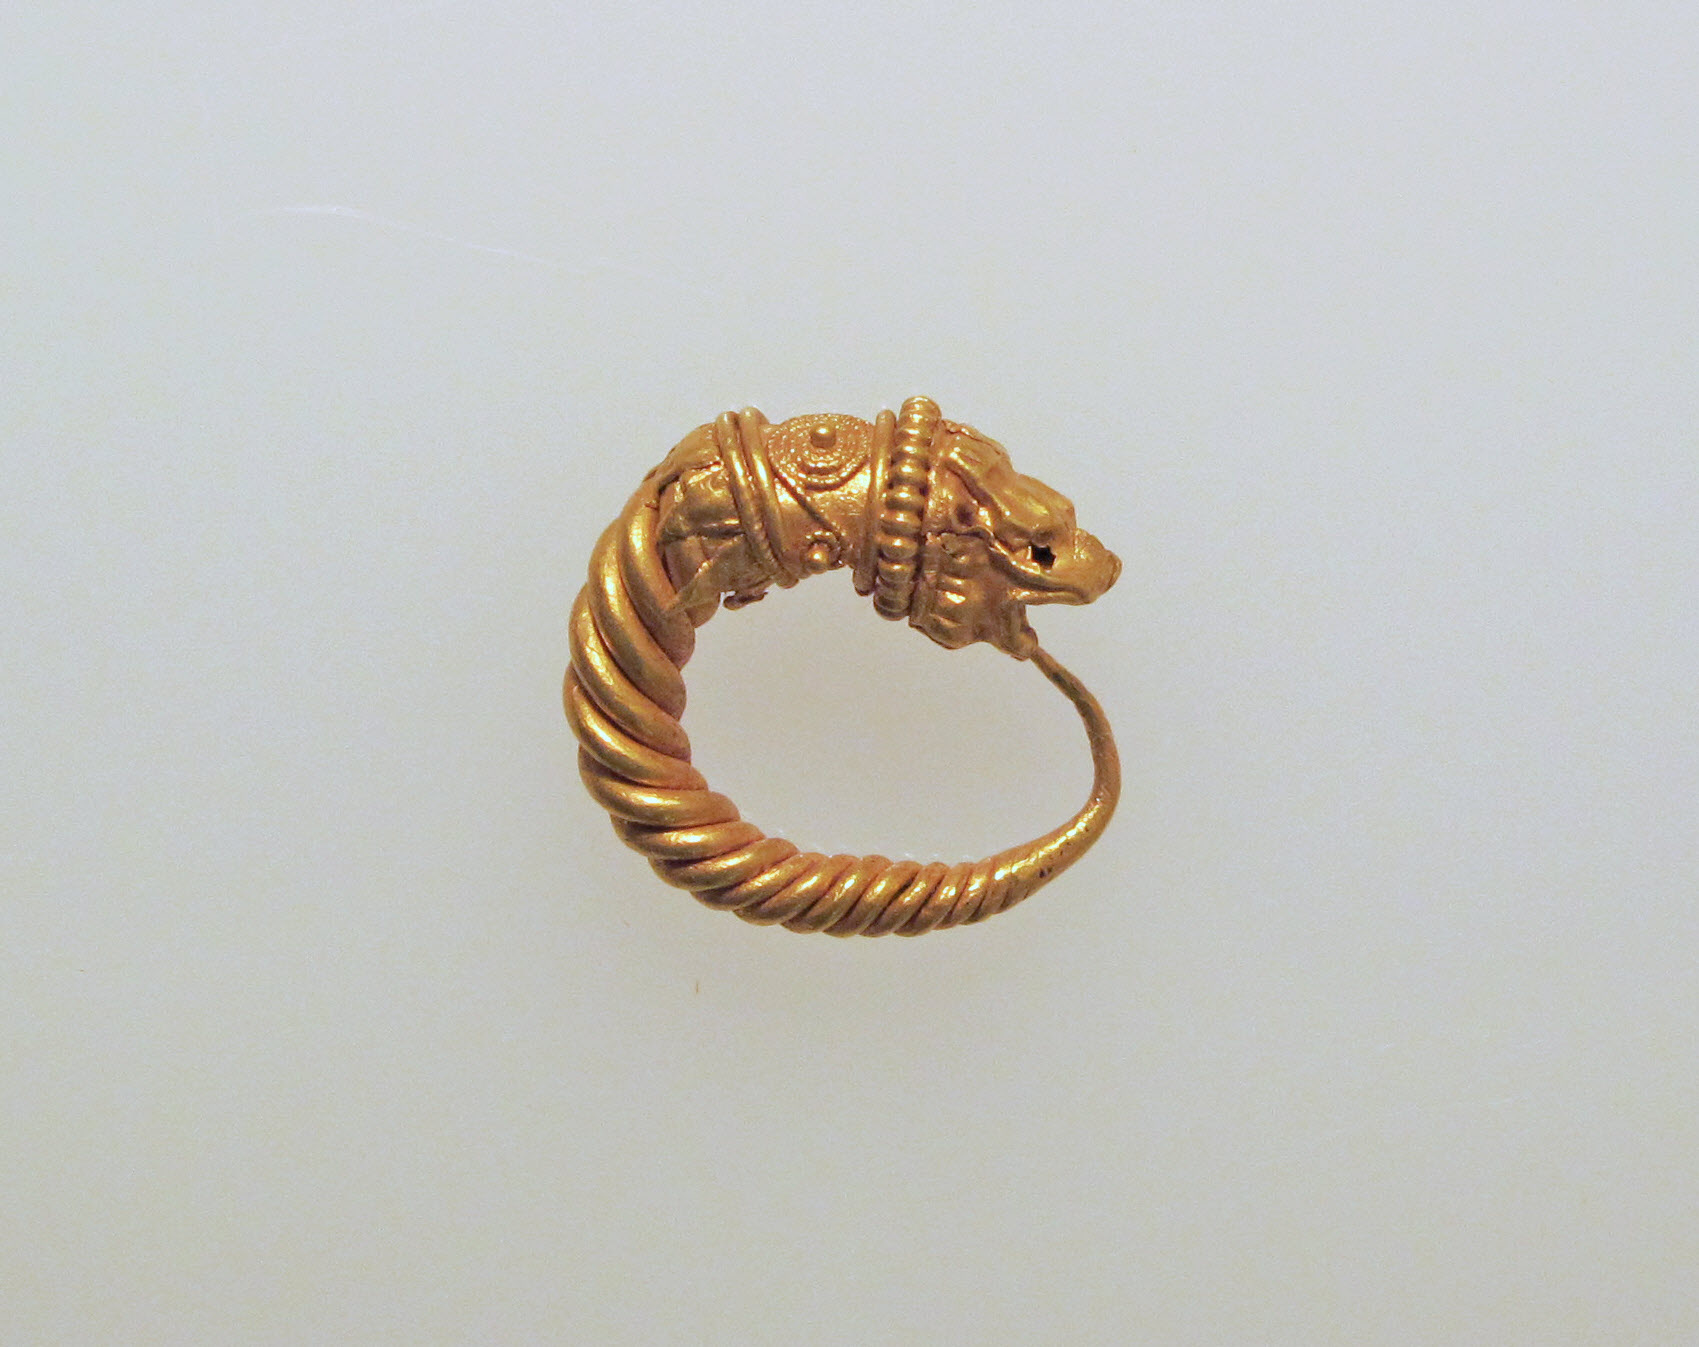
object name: earring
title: Gold earring with head of a lion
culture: greek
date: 400-201 BCE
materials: gold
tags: lions